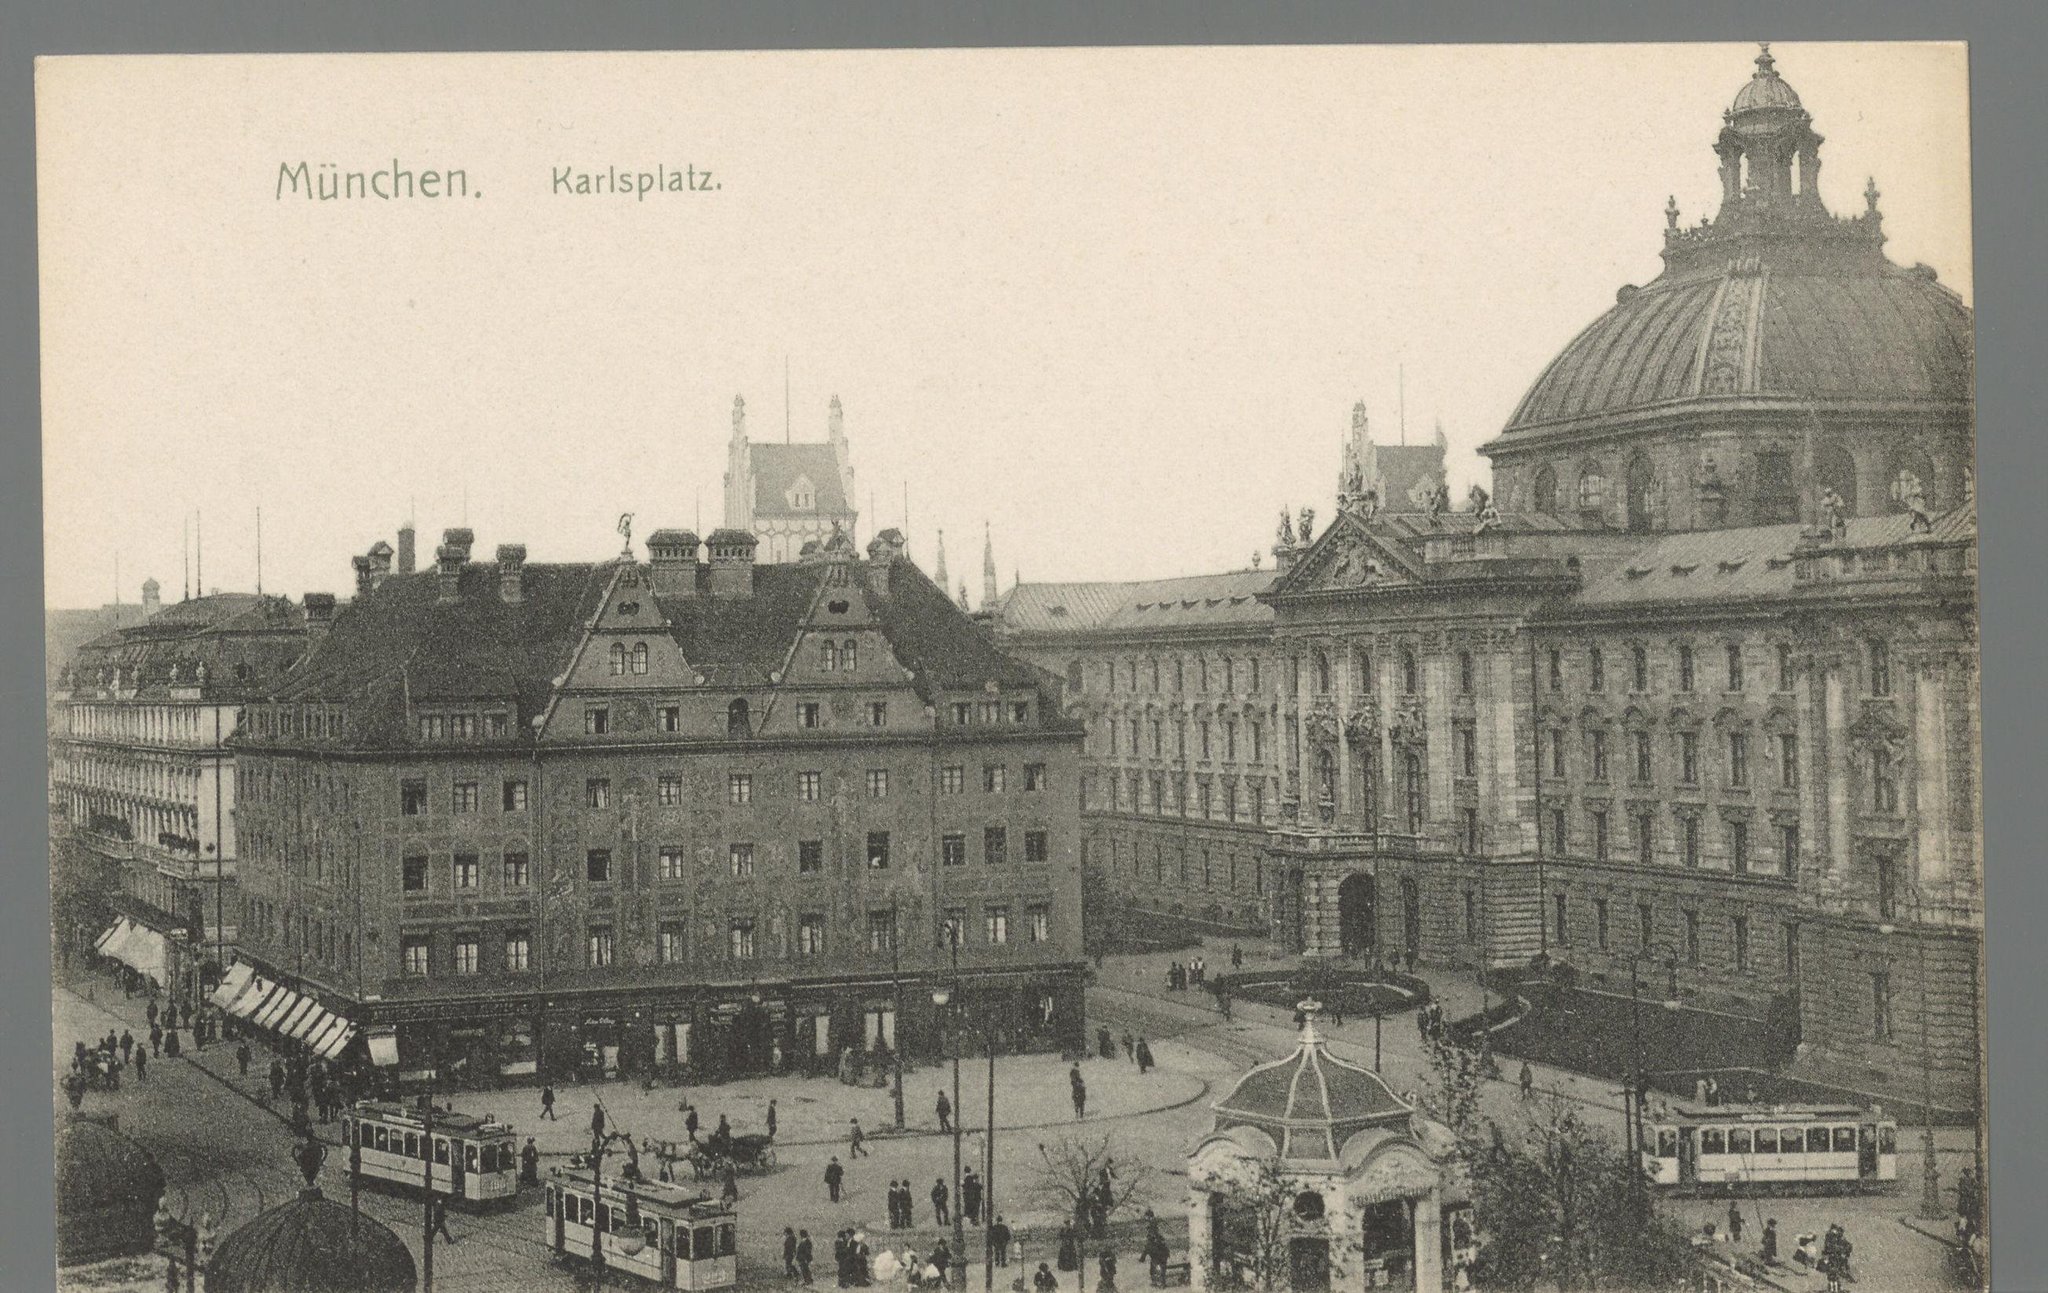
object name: photomechanical print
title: München. Karlsplatz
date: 1905-1930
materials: cardboard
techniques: photograph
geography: munich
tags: square, place, circus, etc.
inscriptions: inscription: ‘W.H.D.’